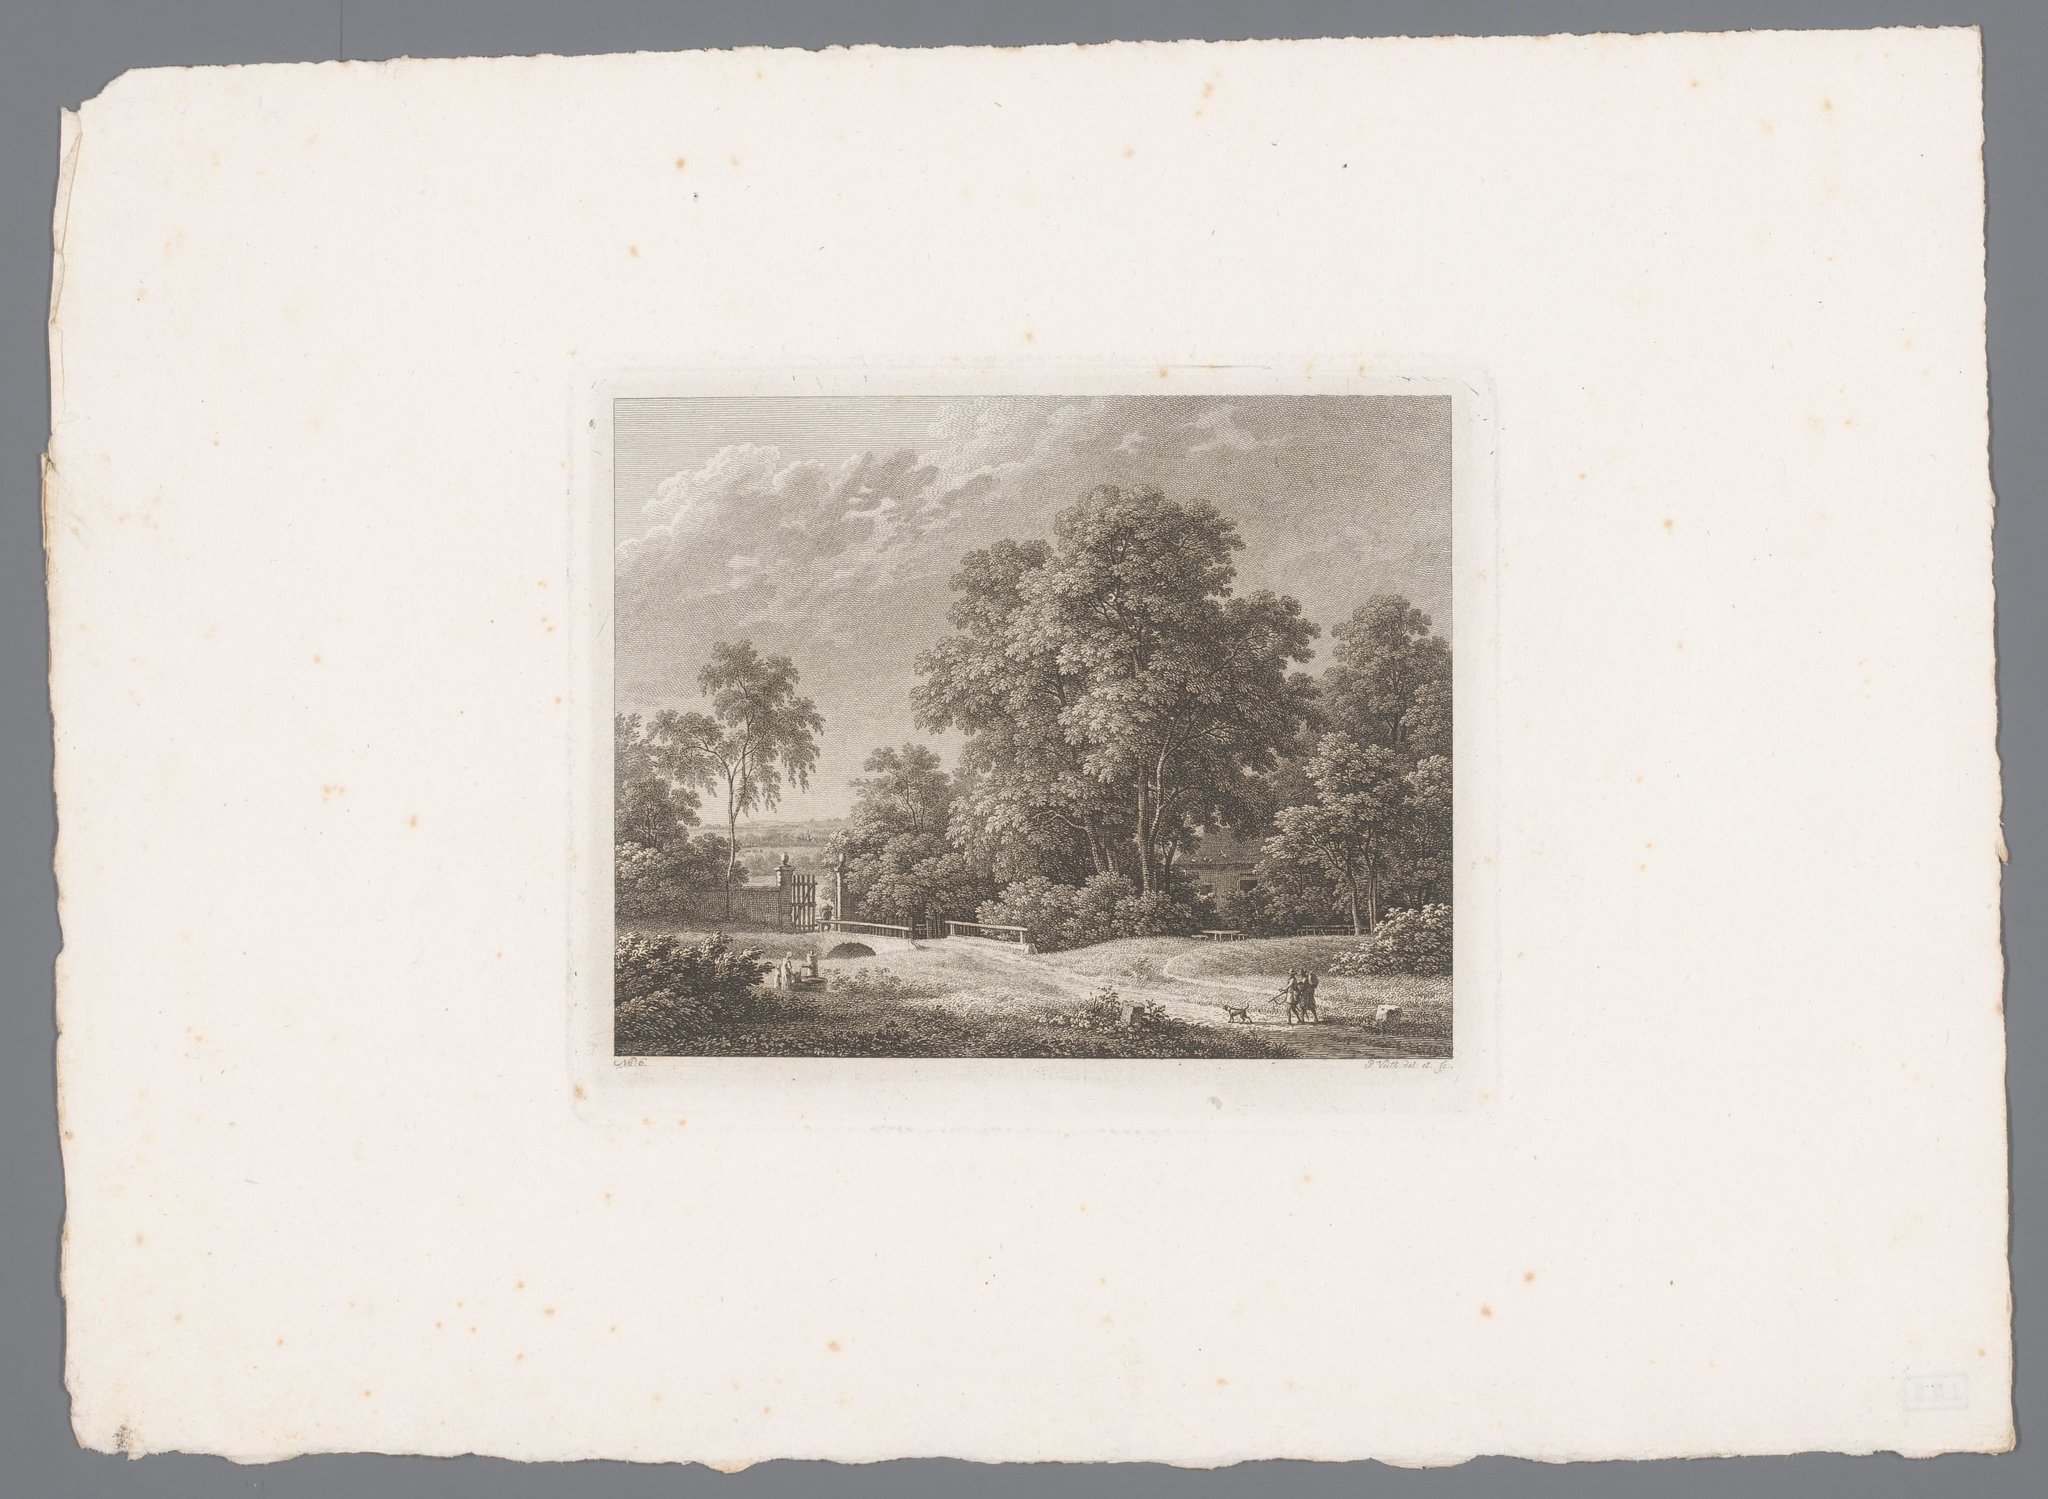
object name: print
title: Landschap met toegangspoort en twee jagers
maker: philipp veith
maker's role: draughtsman, print maker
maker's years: 1768-1837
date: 1822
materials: paper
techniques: etching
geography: dresden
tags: well, landscapes, hunter, gate, entrance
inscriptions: collector's mark: Lugt 2760, collector's mark: Lugt 3976, collector's mark: Lugt 2228